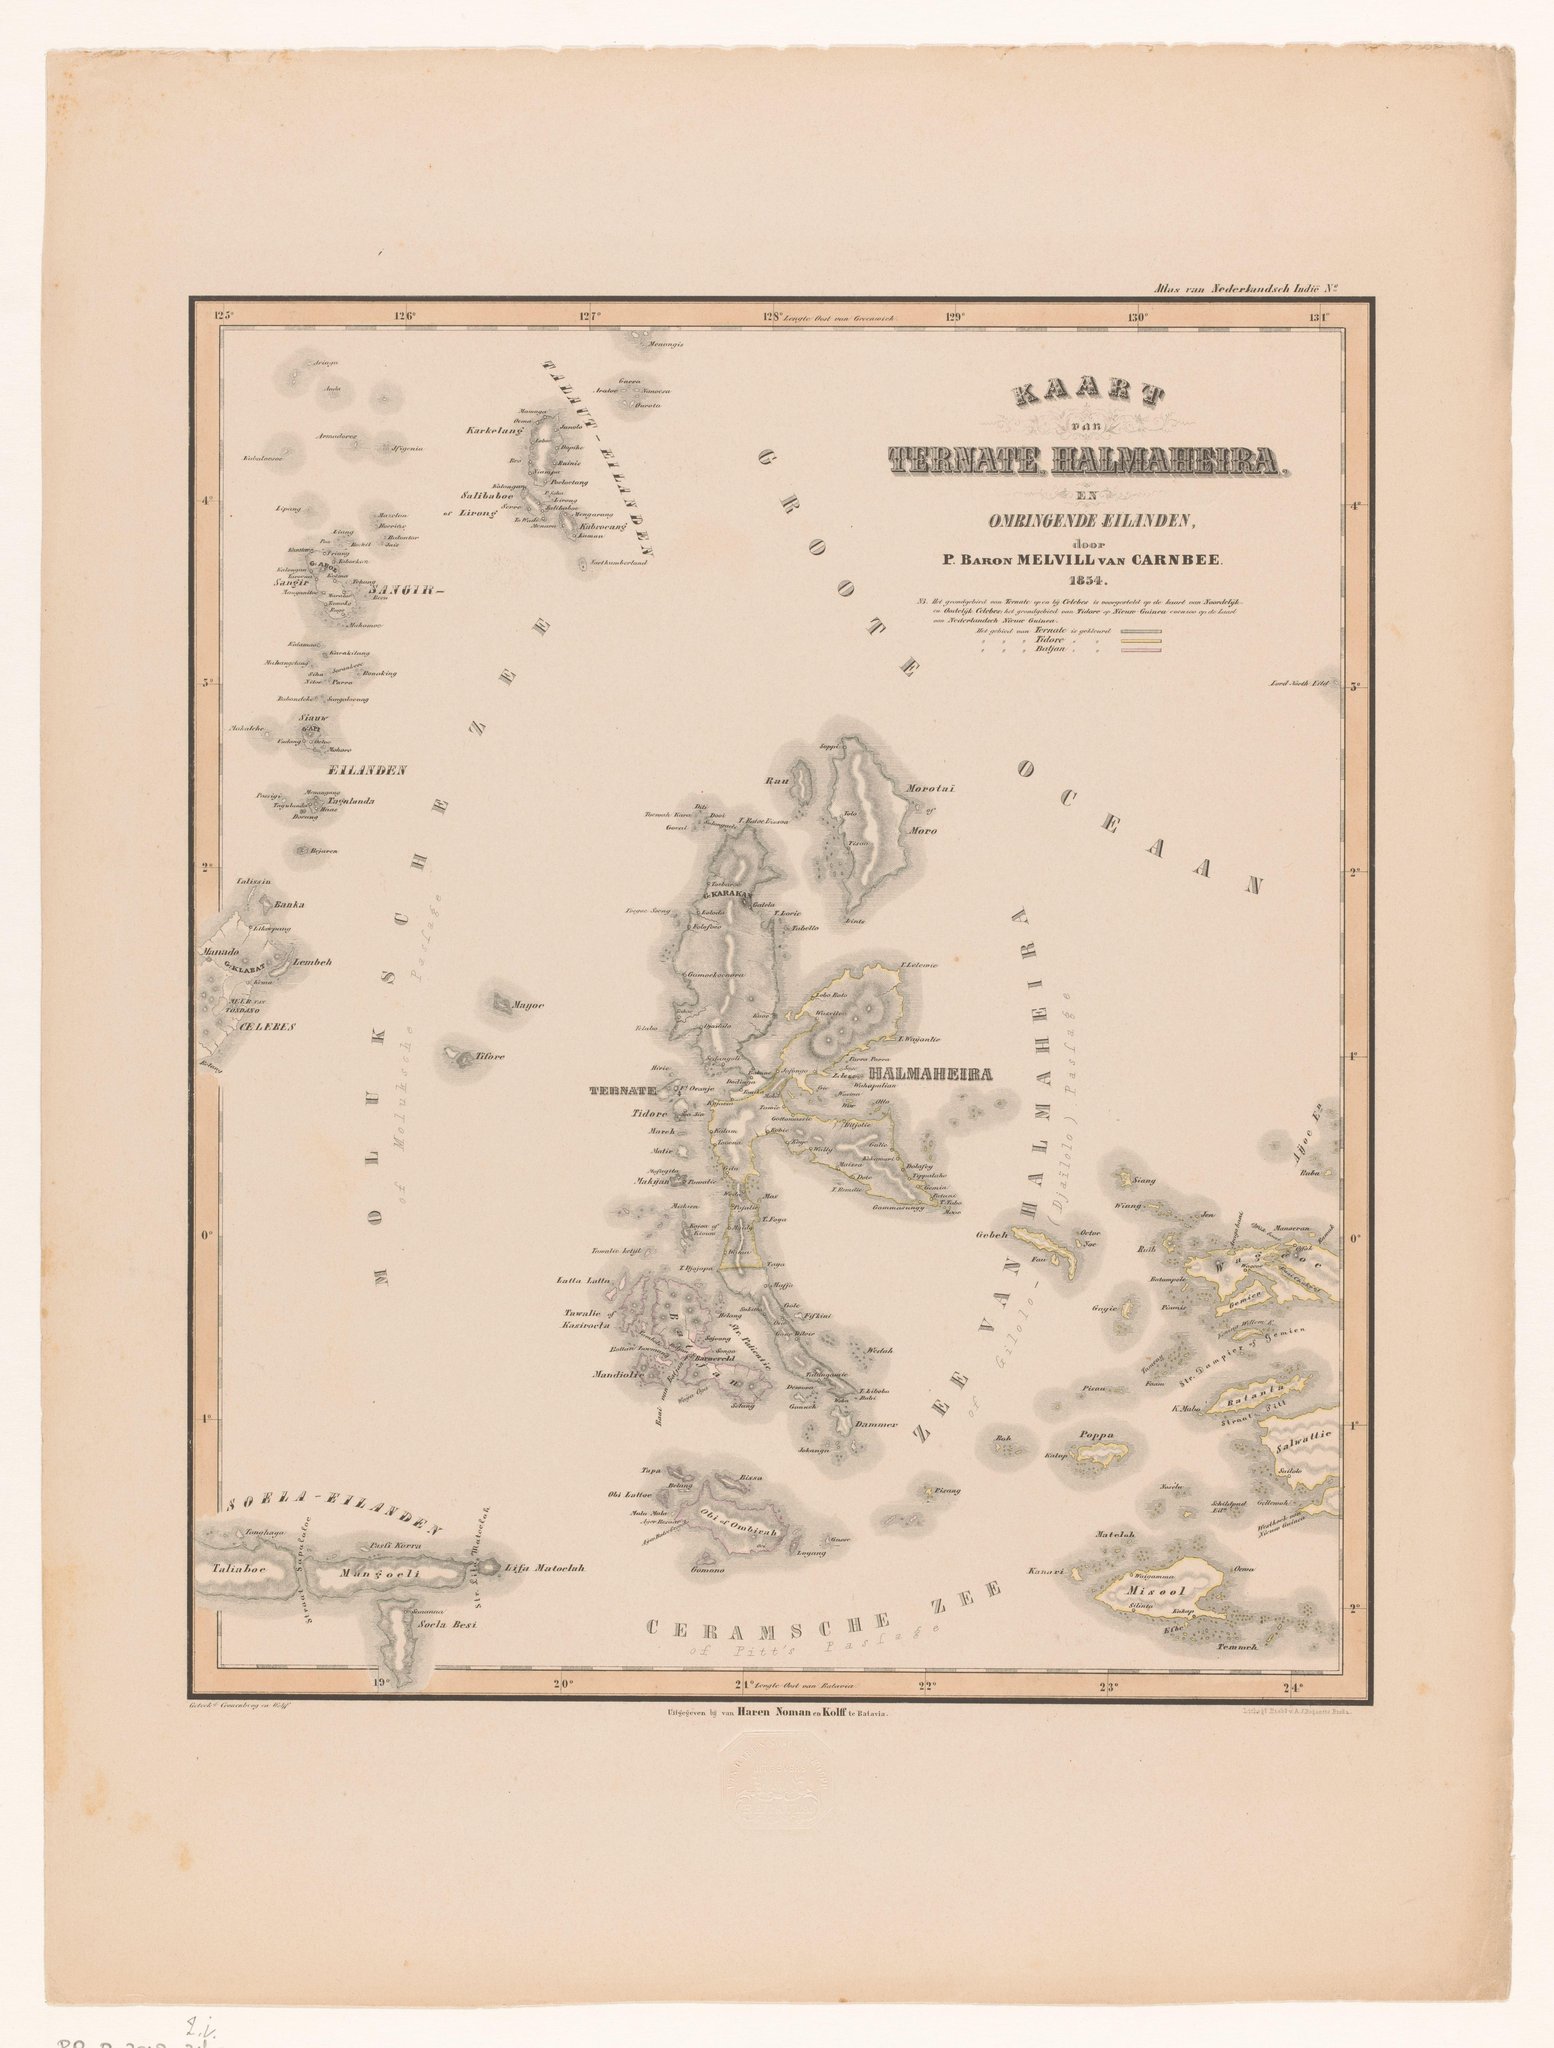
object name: print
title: Kaart van Ternate, Halmaheira en omringende eilanden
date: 1854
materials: paper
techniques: hand coloring, lithograph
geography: breda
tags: marine charts, island (in tropical and sub-tropical regions)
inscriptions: check stamp: ‘Van Haren Noman & Kolff uitgevers te Batavia’, collector's mark: Lugt 2228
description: Op deze kaart zijn Halmahera, Ternate en Pulau Obi centraal afgebeeld. Links een uitloper van Celebes met daarboven Pulau Thulandang, Pulau Sangihe en Pulau Krakelong met de daartussen gelegen kleinere eilanden. Links onderin de eilanden Pulau Taliabu, Pulau Mangoli en Pulau Sulabes. Misool en Waigeo en de uiterste punt van West-Papoea zijn rechts onderin afgebeeld. Grenskleuring geeft de begrenzing van drie koninkrijken aan.